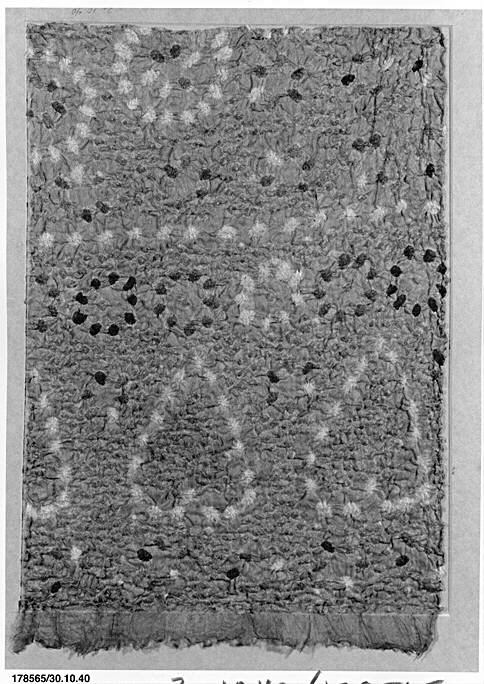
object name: piece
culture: japanese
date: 1801-1900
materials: silk